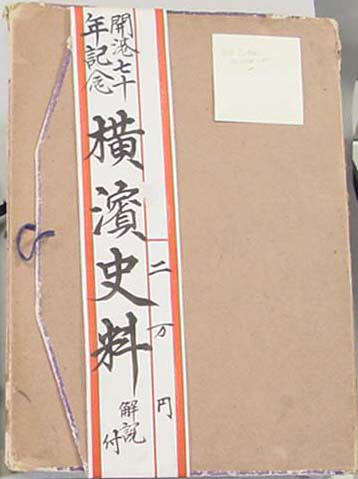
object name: illustrated book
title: Seventieth Anniversary of the Opening of Yokohama Port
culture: japanese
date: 1928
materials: ink, paper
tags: ships